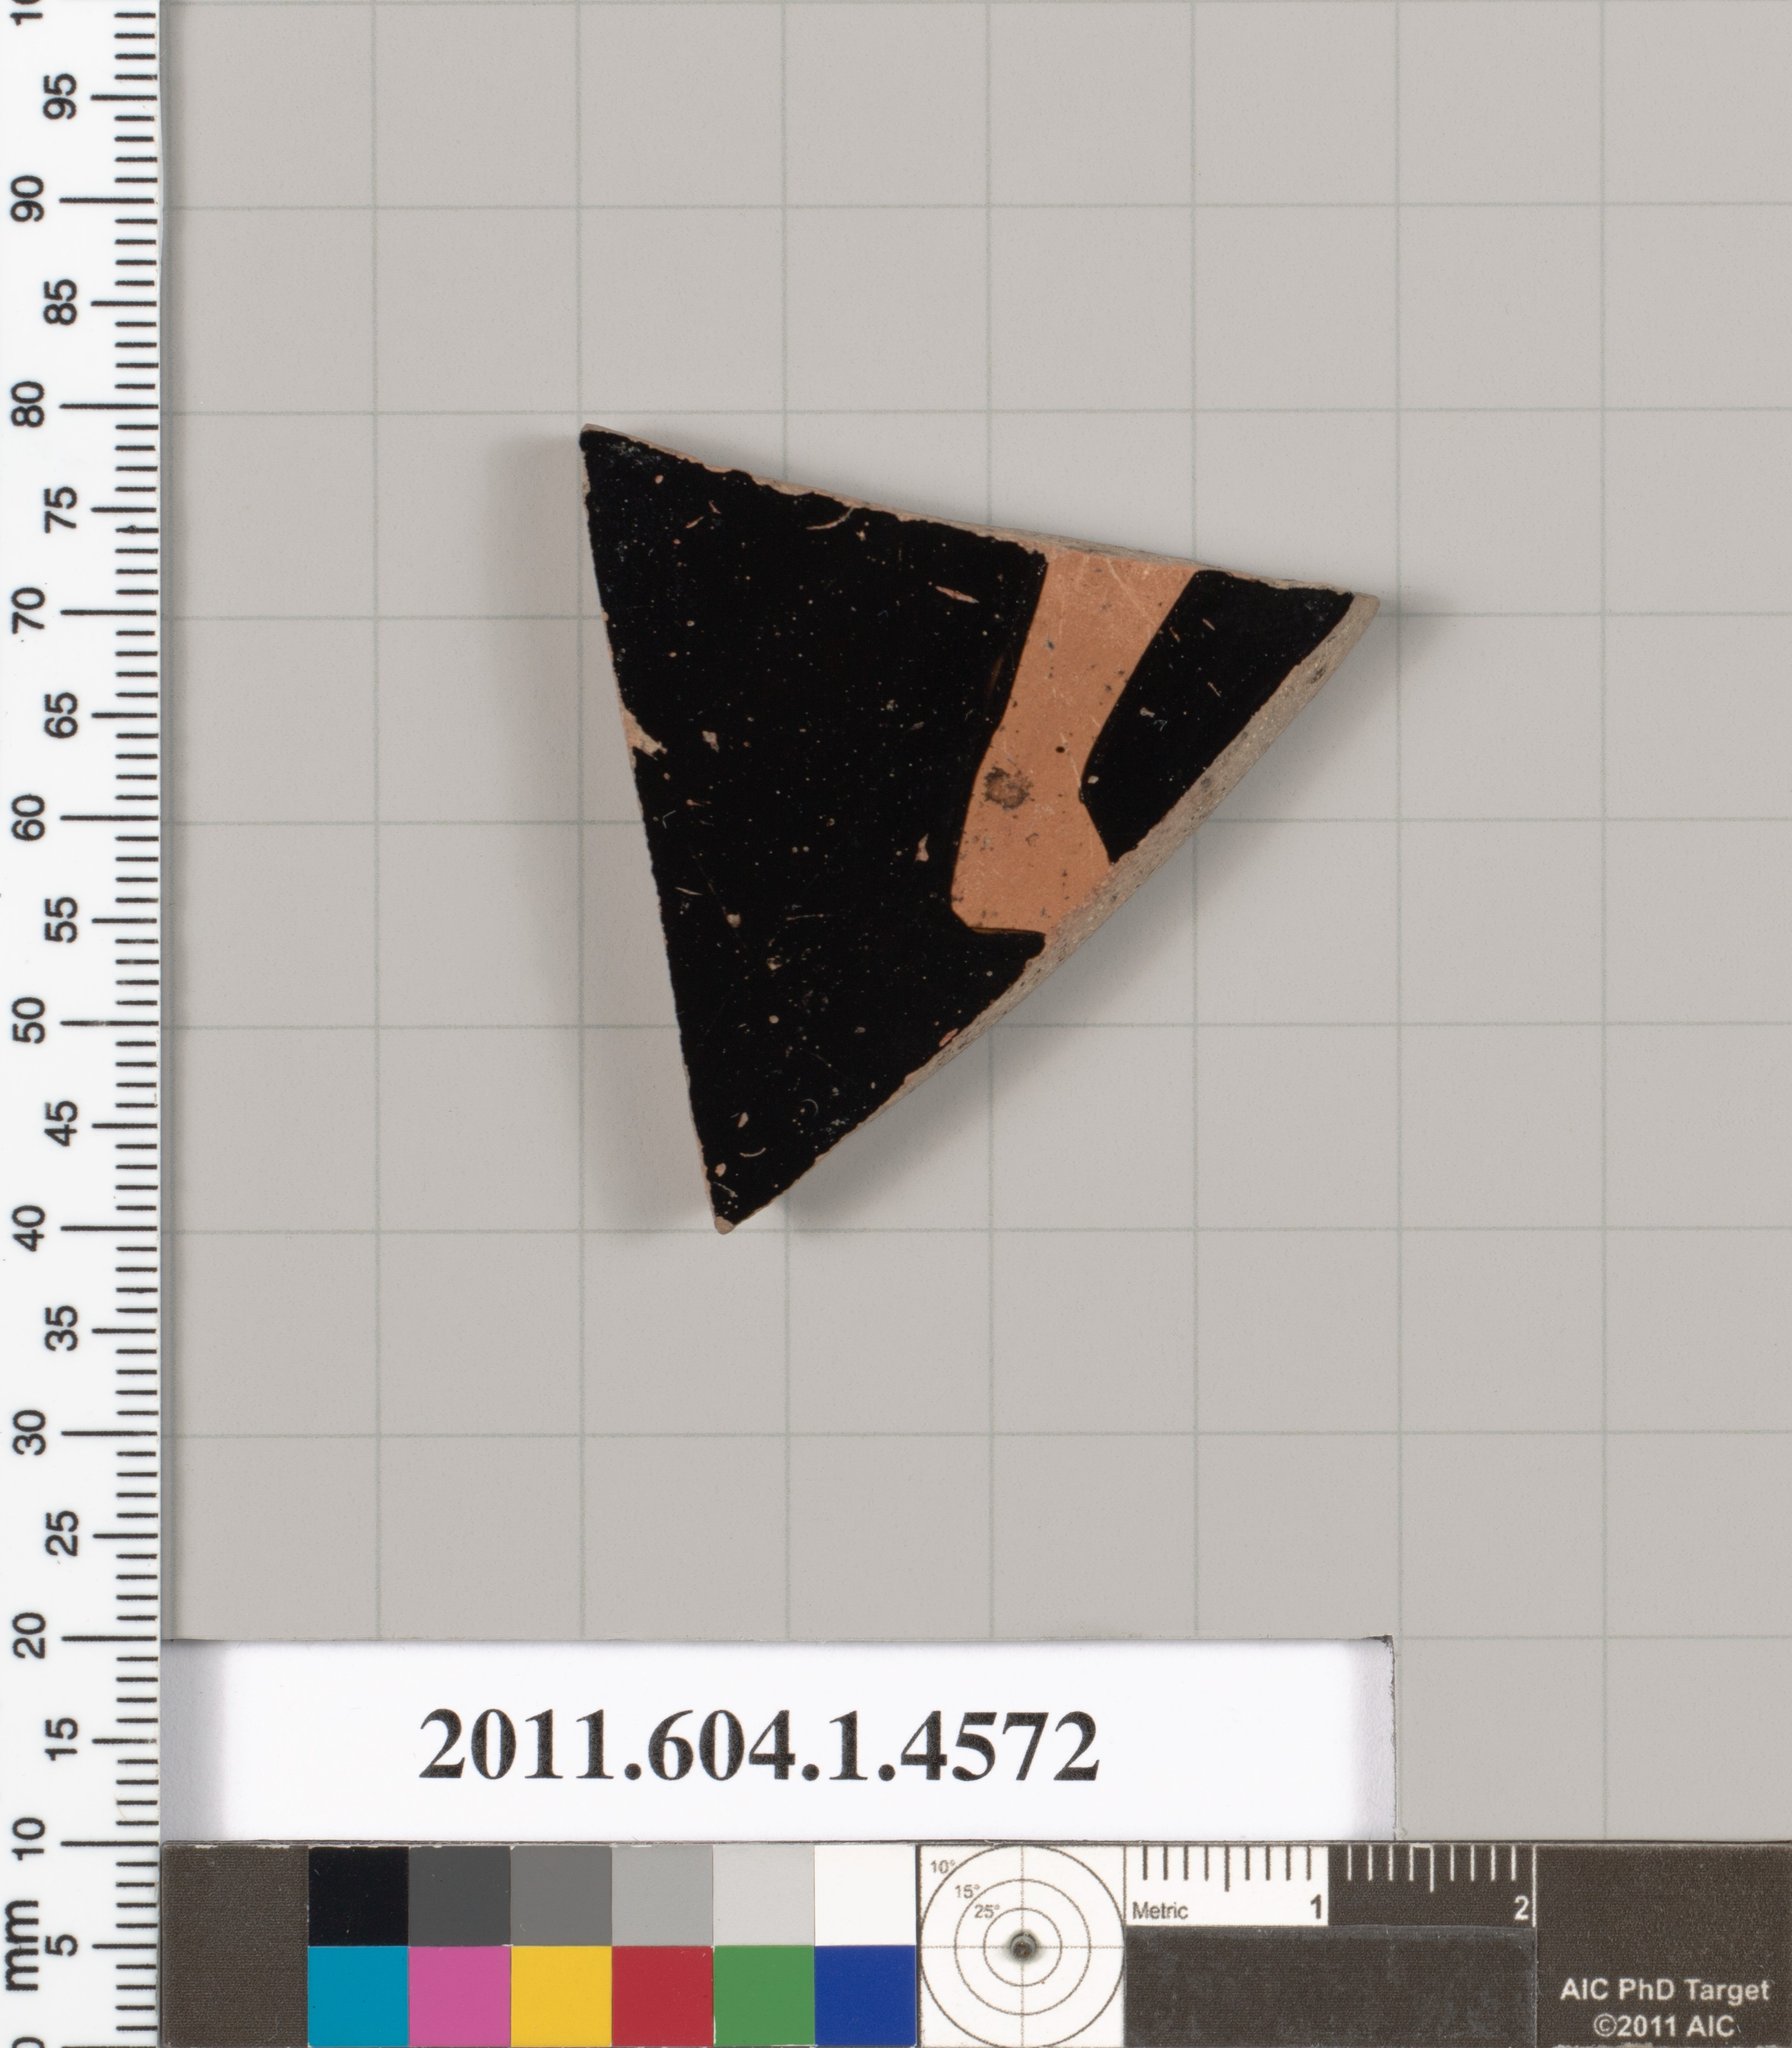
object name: kylix fragment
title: Terracotta fragment of a kylix (drinking cup)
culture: greek, attic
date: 500-476 BCE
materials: terracotta